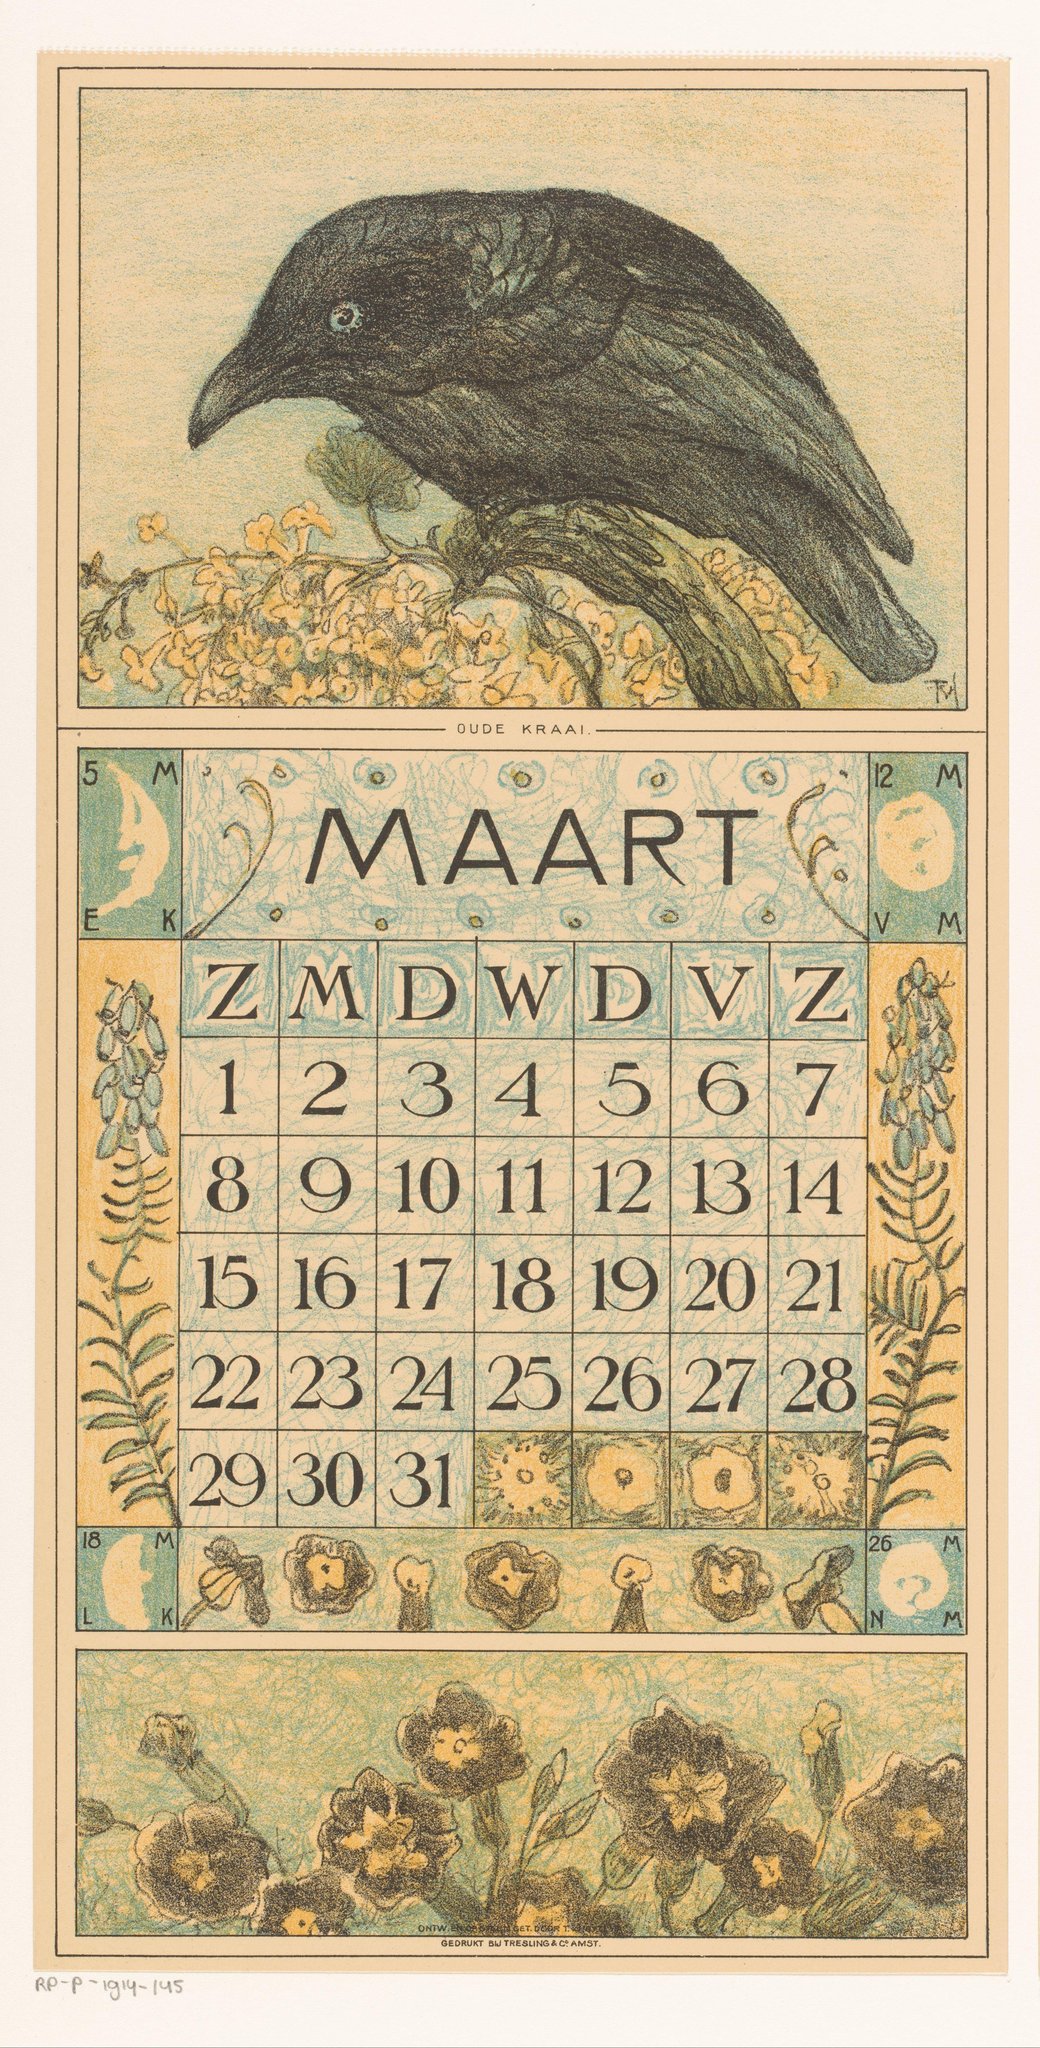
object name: calendar leaf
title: Kalenderblad maart met kraai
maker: theo van hoytema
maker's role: draughtsman, painter, print maker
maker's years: 1863-1917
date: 1913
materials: paper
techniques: lithograph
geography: the hague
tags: song-birds: crow, lunar year, march ~ other concepts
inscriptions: collector's mark: Lugt 2228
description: In de ornamentrand en onderin bloemen. In de hoeken de standen van de maan op vier dagen. Bovenaan het blad een scheurlijn.